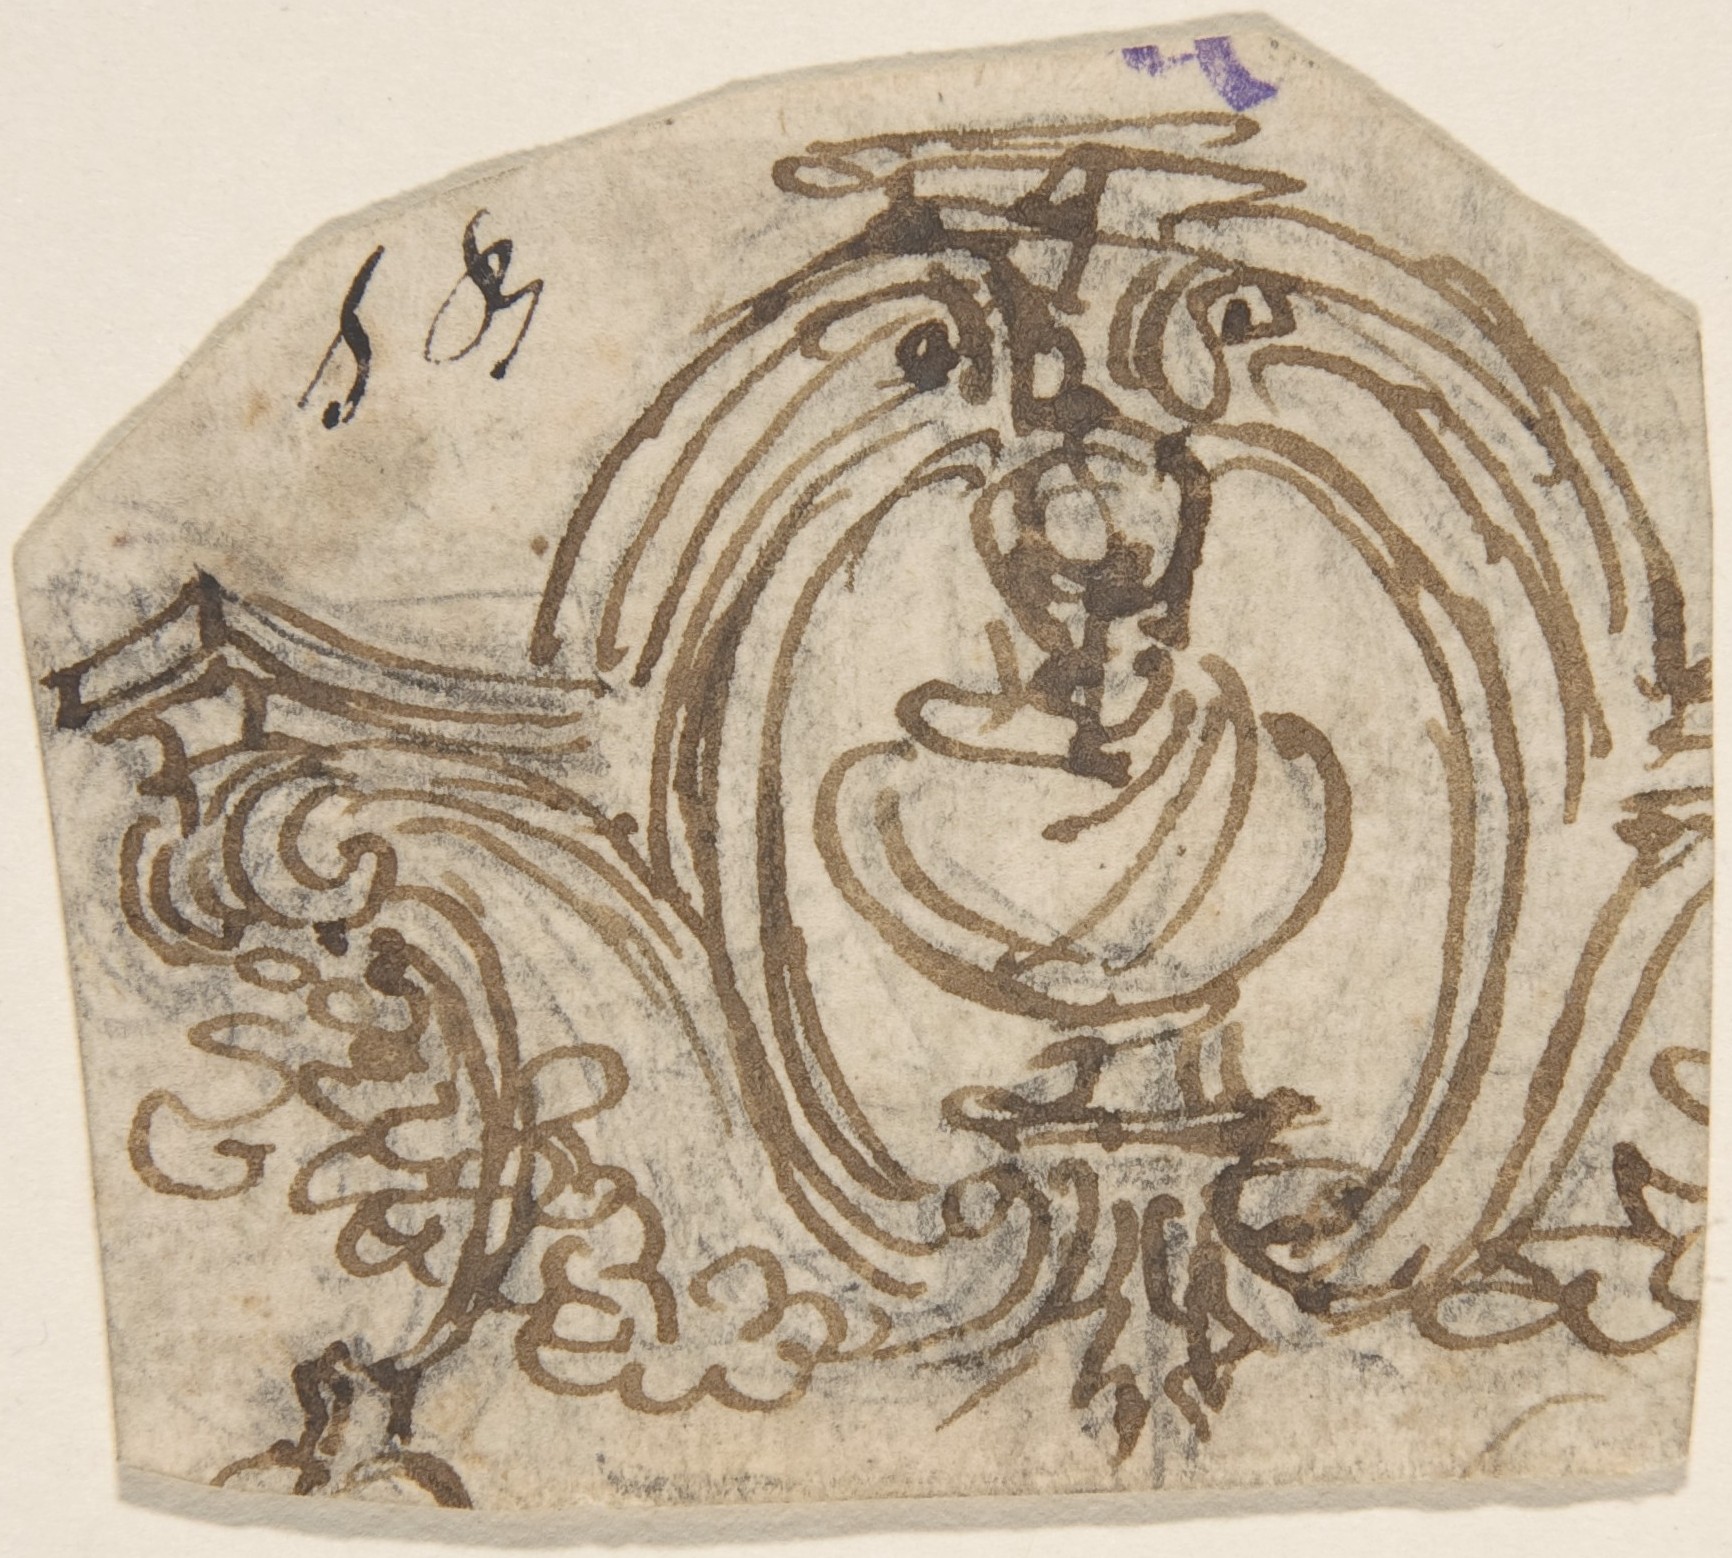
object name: drawing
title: Design for an Overdoor with a Bust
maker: giovanni battista foggini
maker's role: artist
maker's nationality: italian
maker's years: 1652-1725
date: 1672-1725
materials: chalk, ink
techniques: pen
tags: human figures